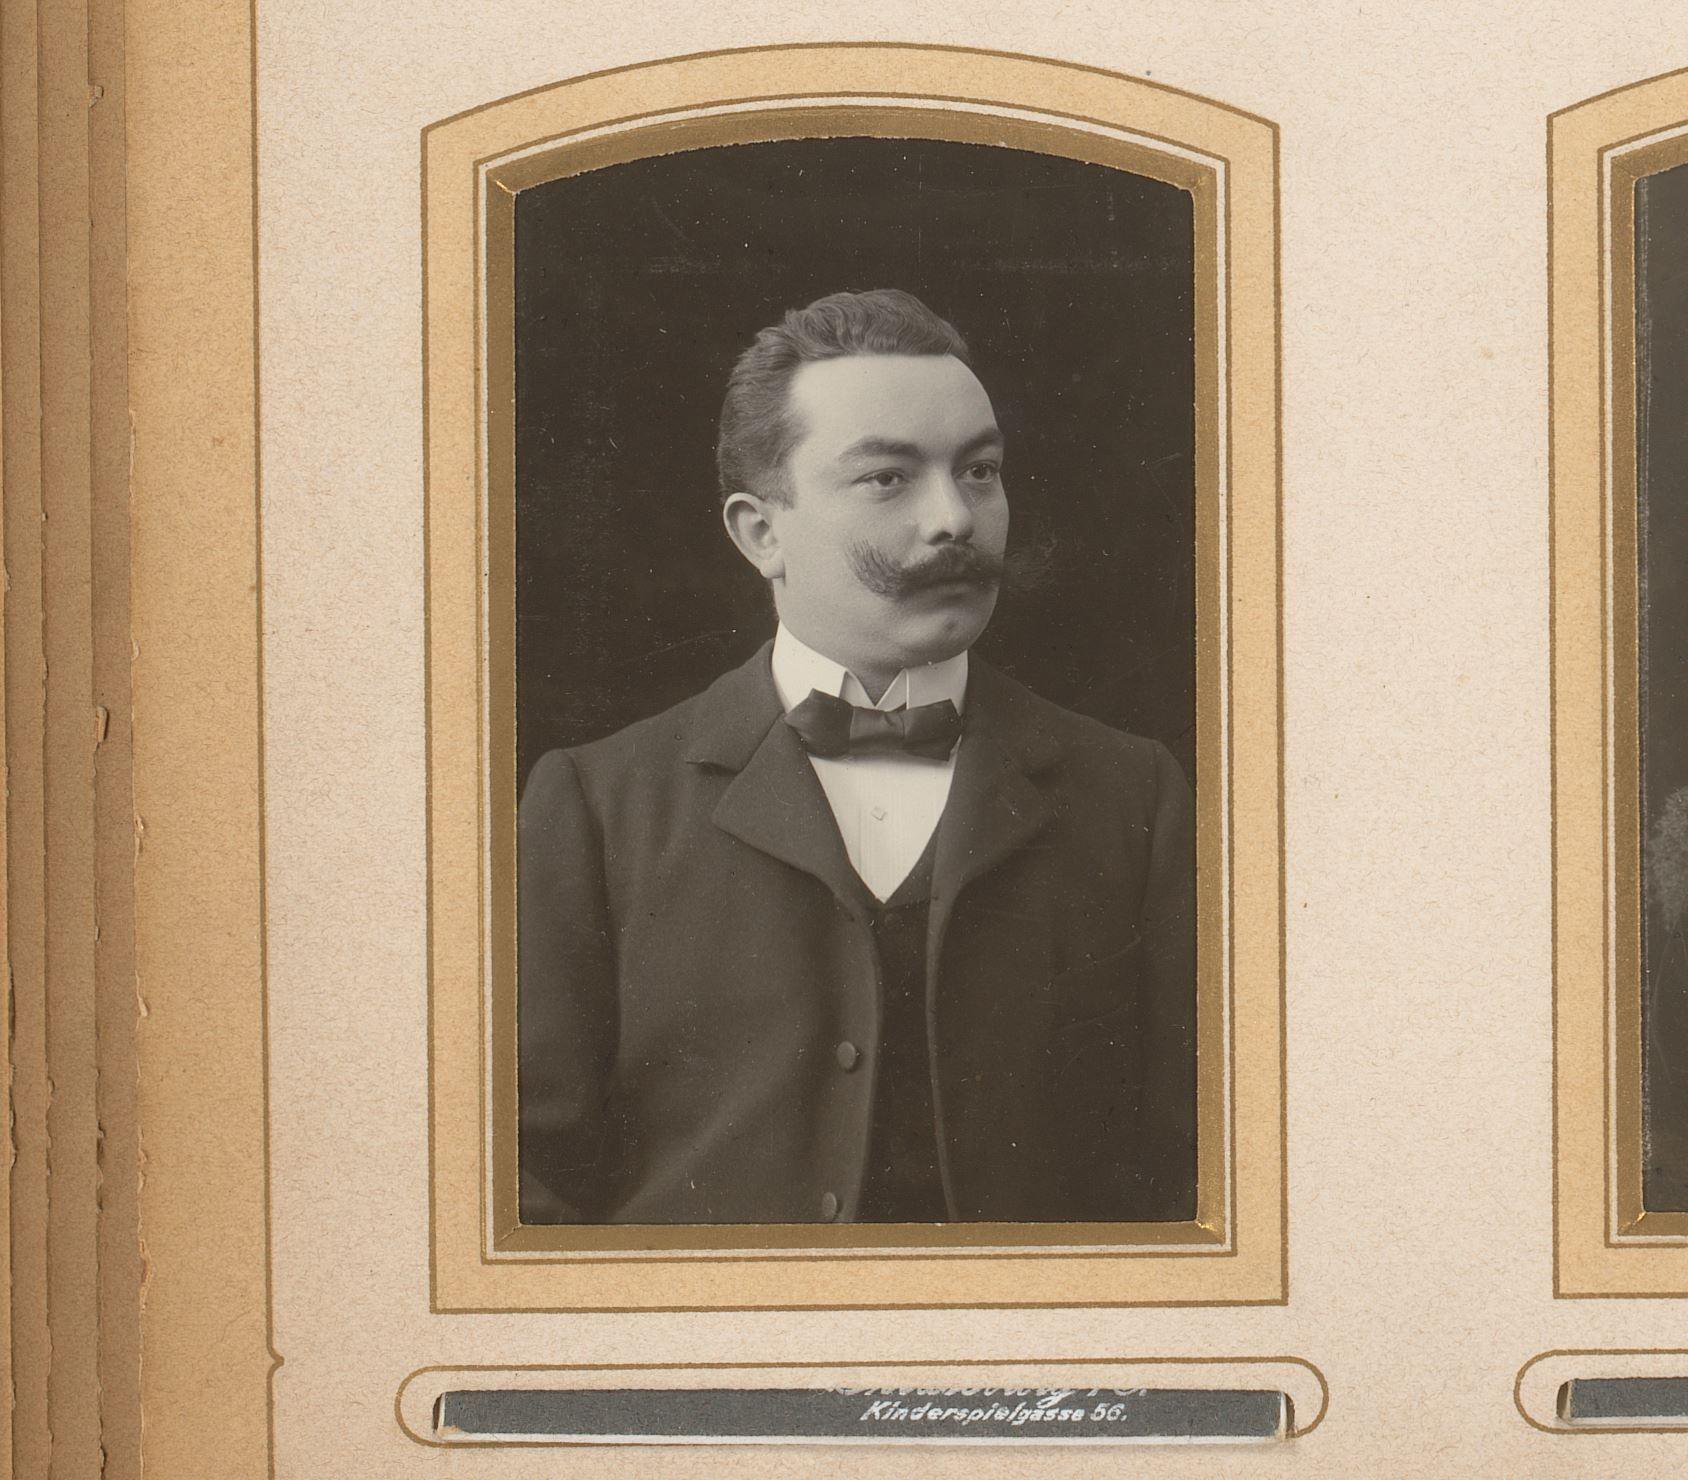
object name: carte de visite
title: Portret van een man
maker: jos dentel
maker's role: fotograaf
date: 1880-1920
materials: cardboard, photographic support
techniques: collodion silver print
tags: adult man, historical persons